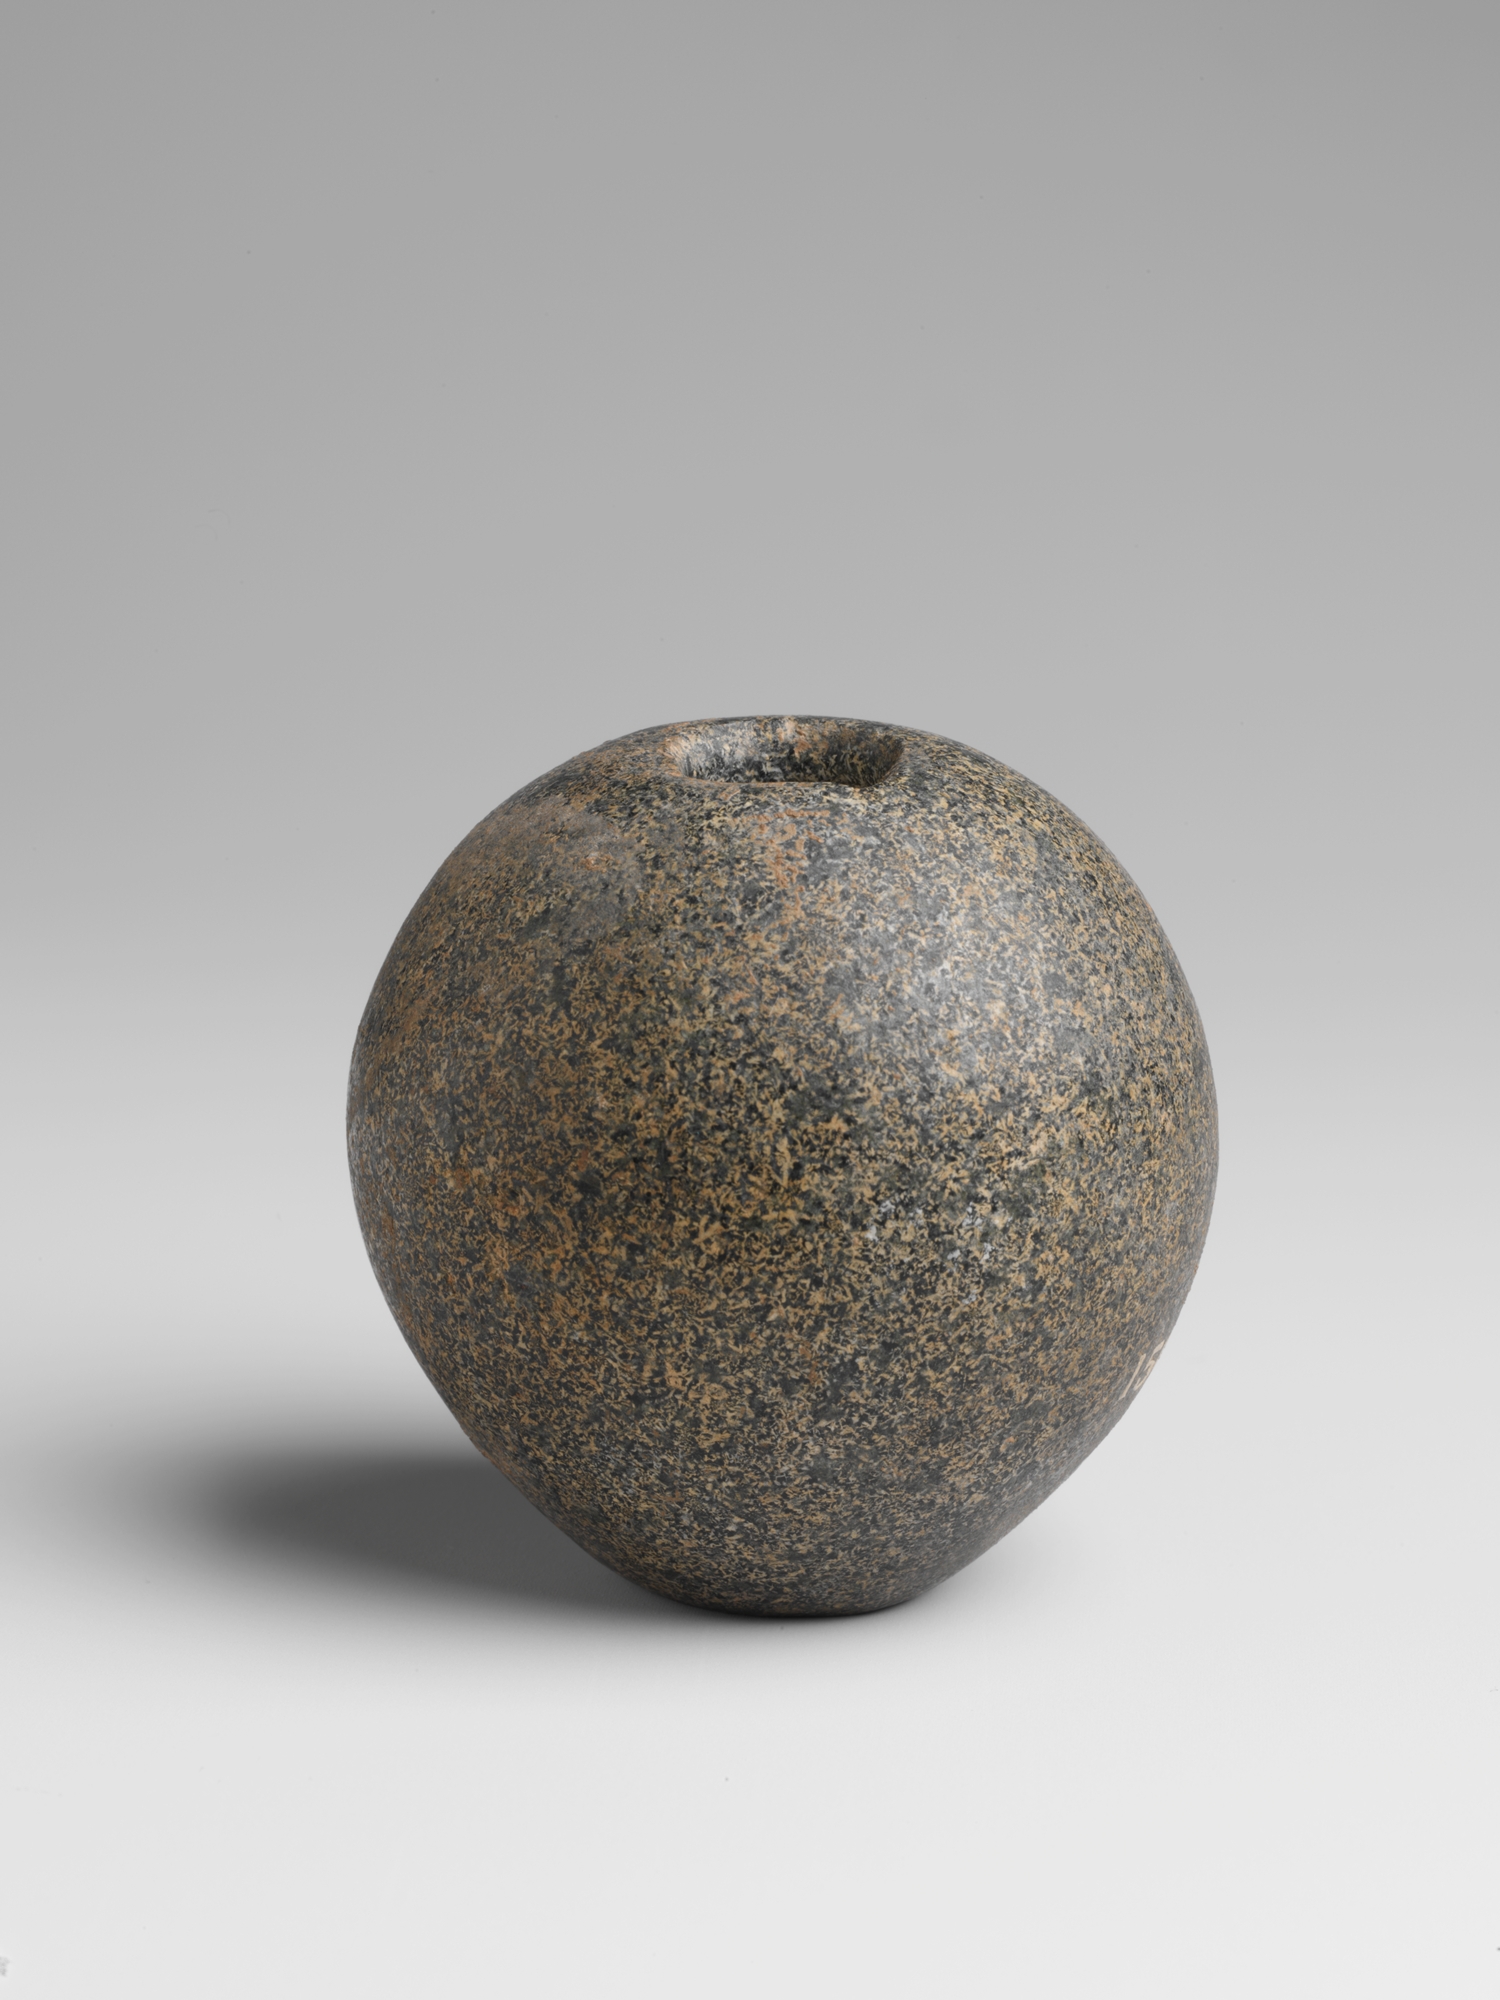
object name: mace head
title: Gabbro mace head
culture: cypriot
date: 2500-1900 BCE